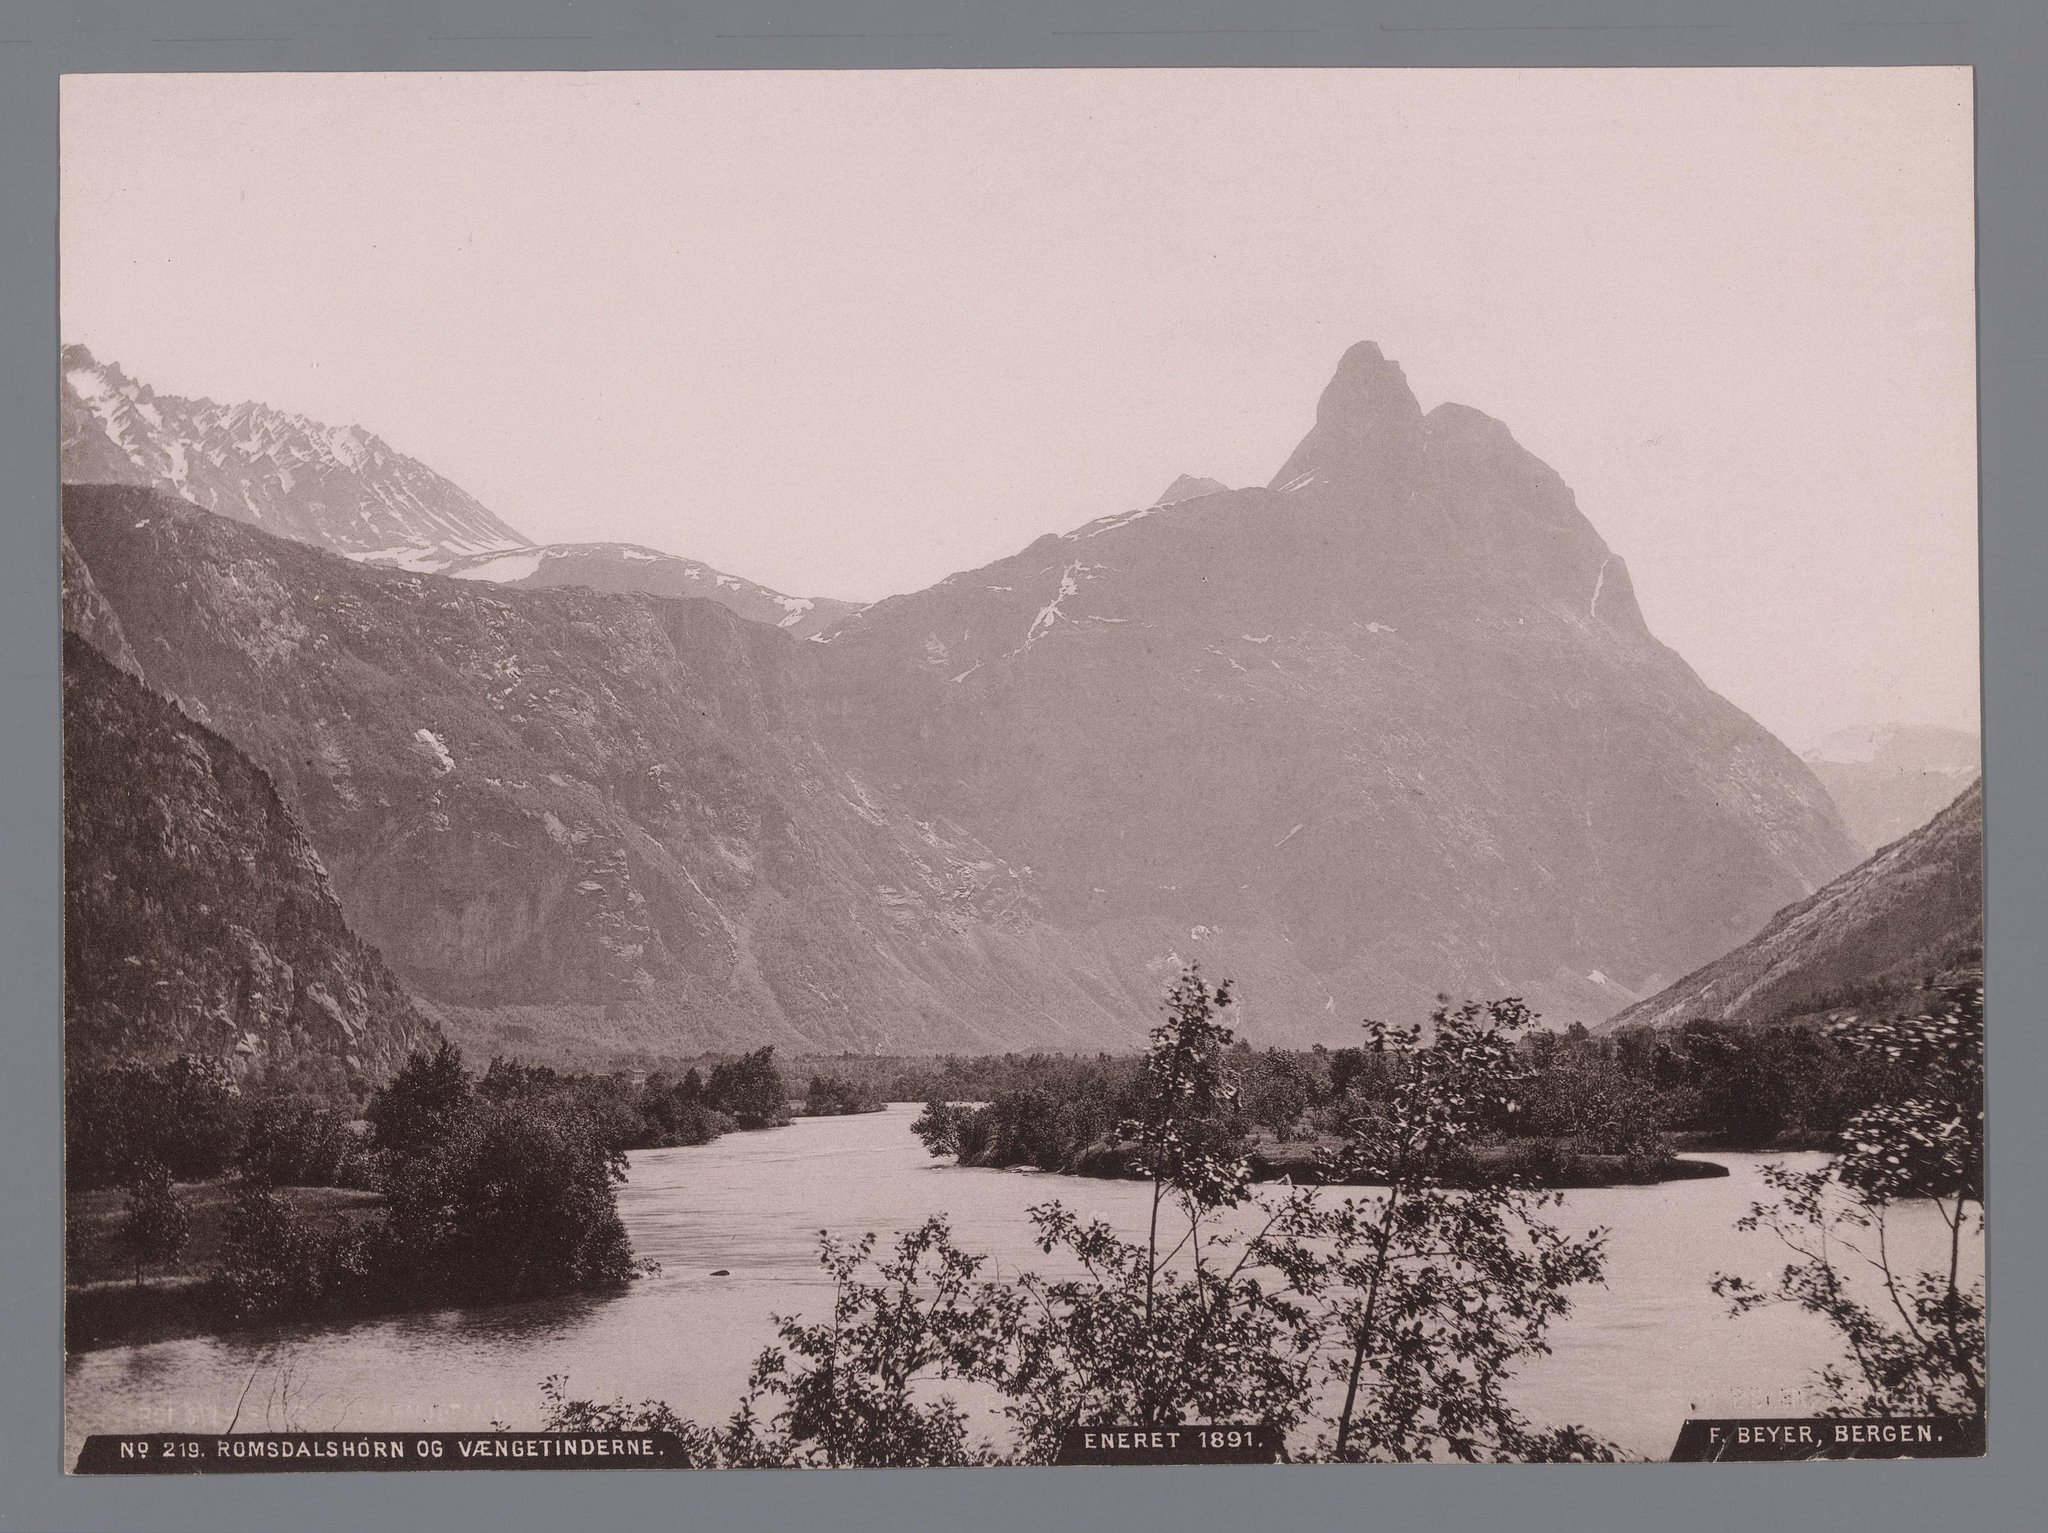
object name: photomechanical print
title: Romsdalshorn og vængetinderne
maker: Anonymous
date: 1891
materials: paper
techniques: photograph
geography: bergen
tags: mountains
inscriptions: copyright notice: ‘ENERET 1891.’, number: ‘No 219.’